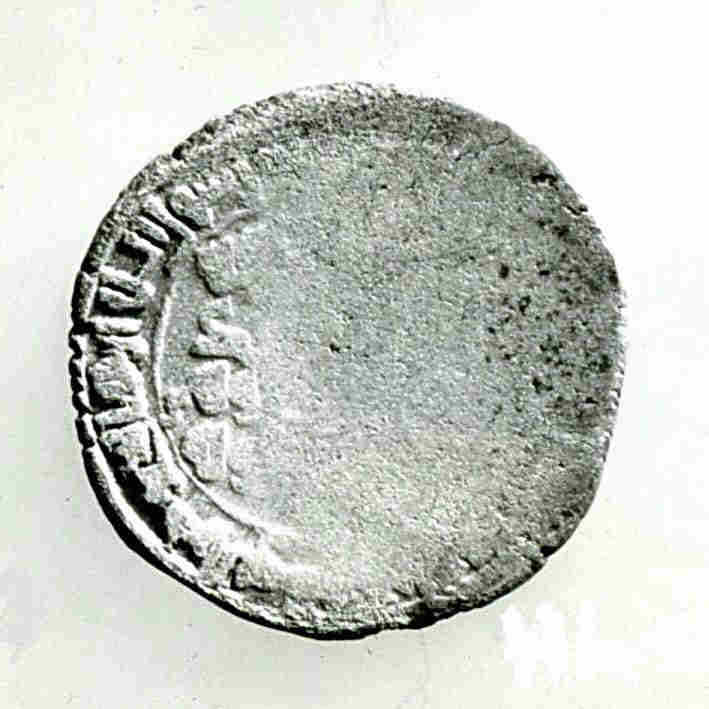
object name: coin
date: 970-997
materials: silver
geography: iran